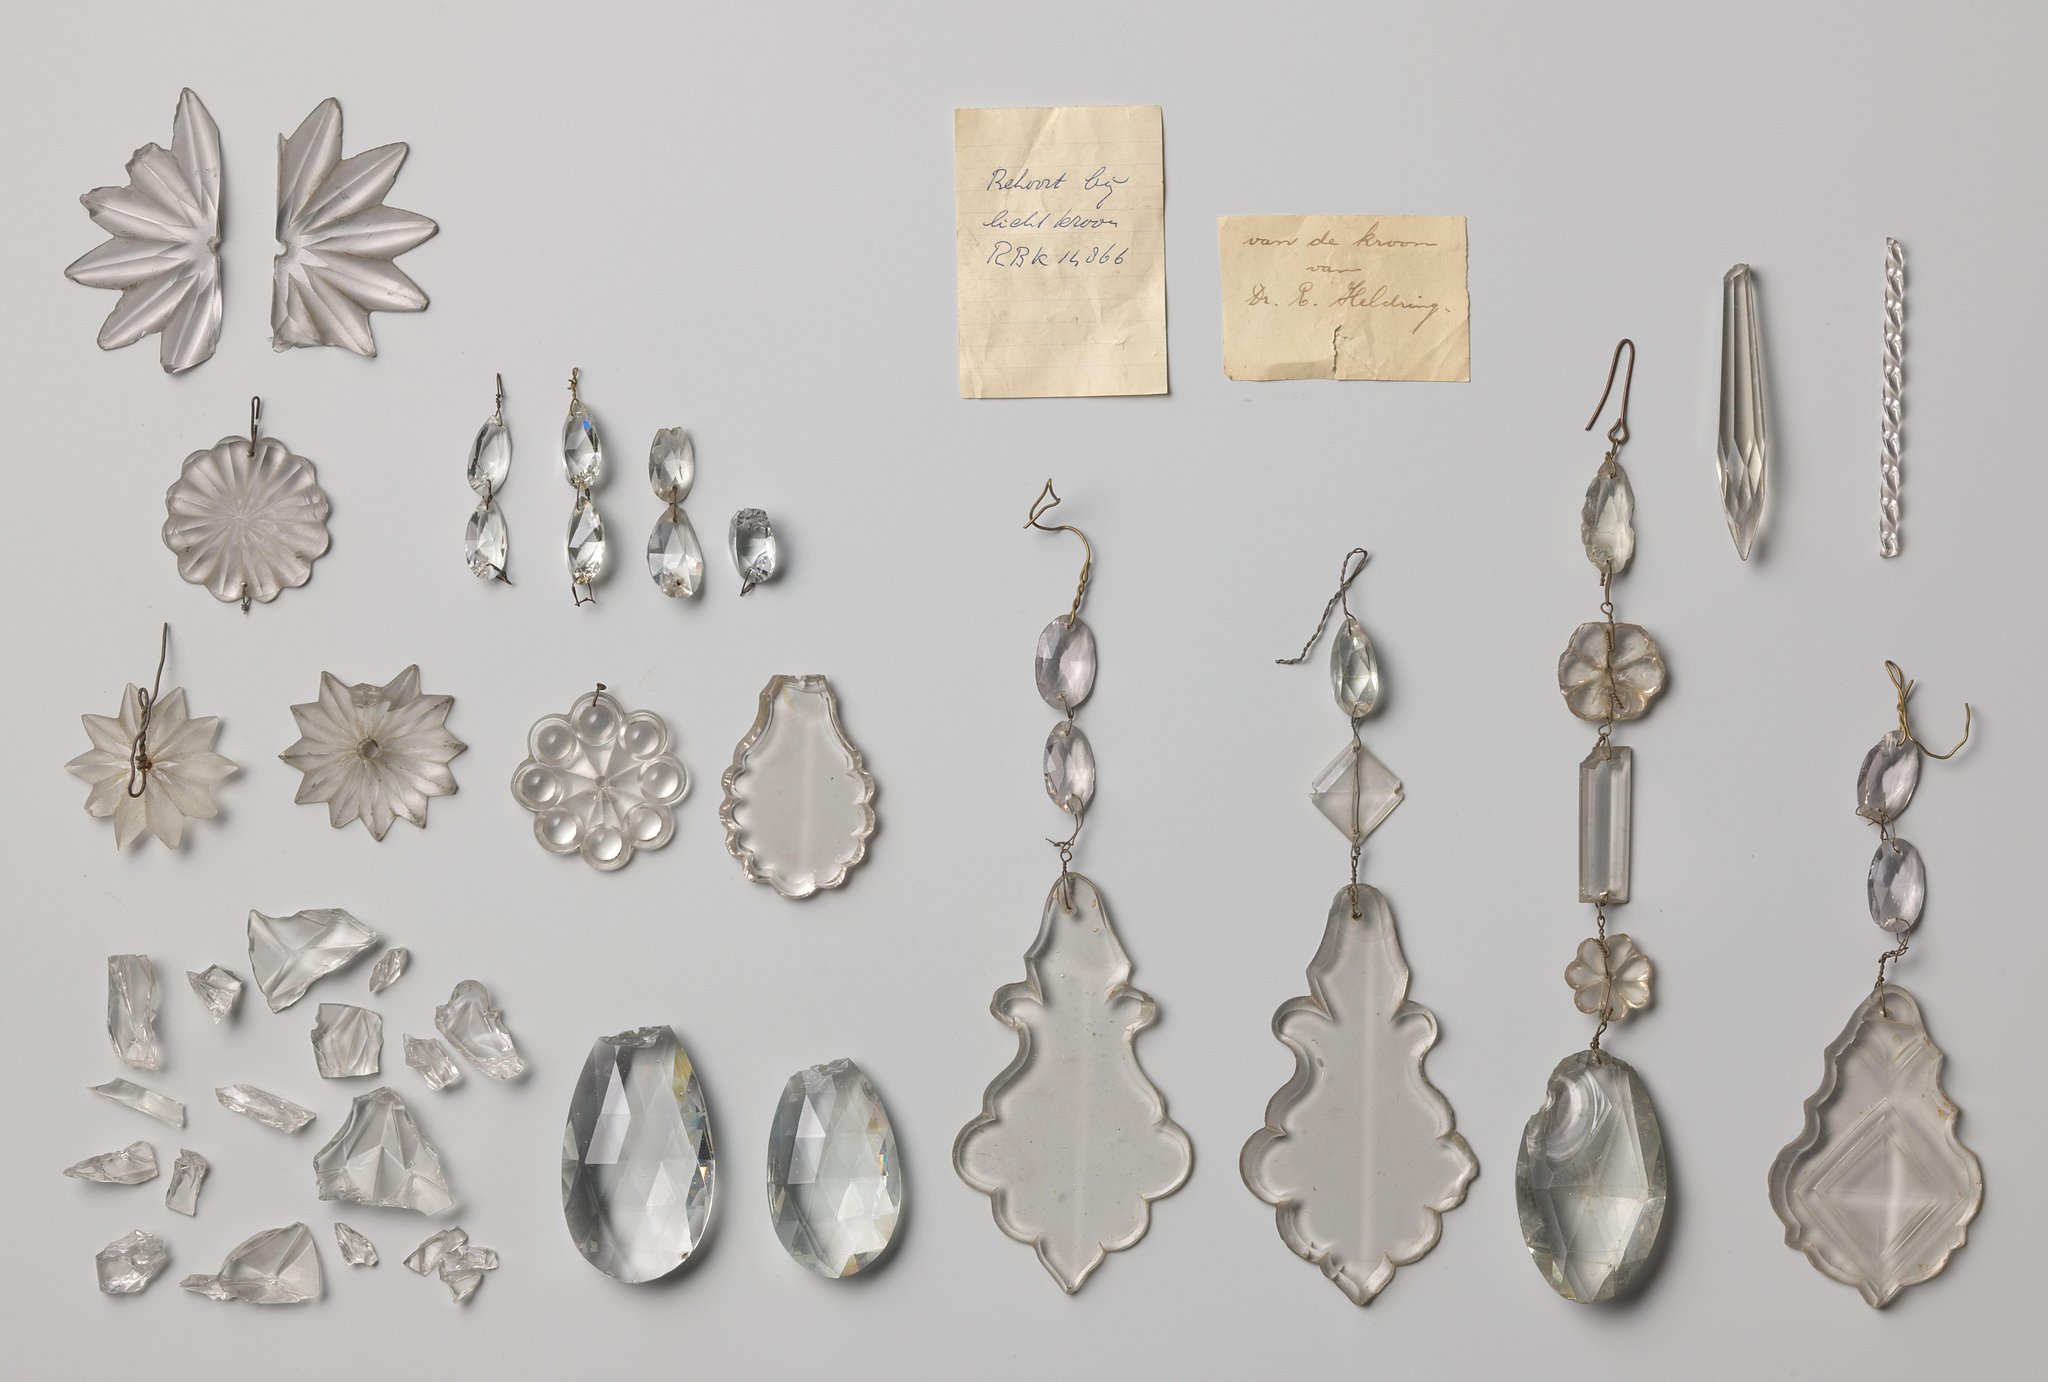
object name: chandelier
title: Glas horend bij een kroonluchter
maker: Anonymous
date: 1785-1800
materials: glass, iron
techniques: gilding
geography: northern netherlands